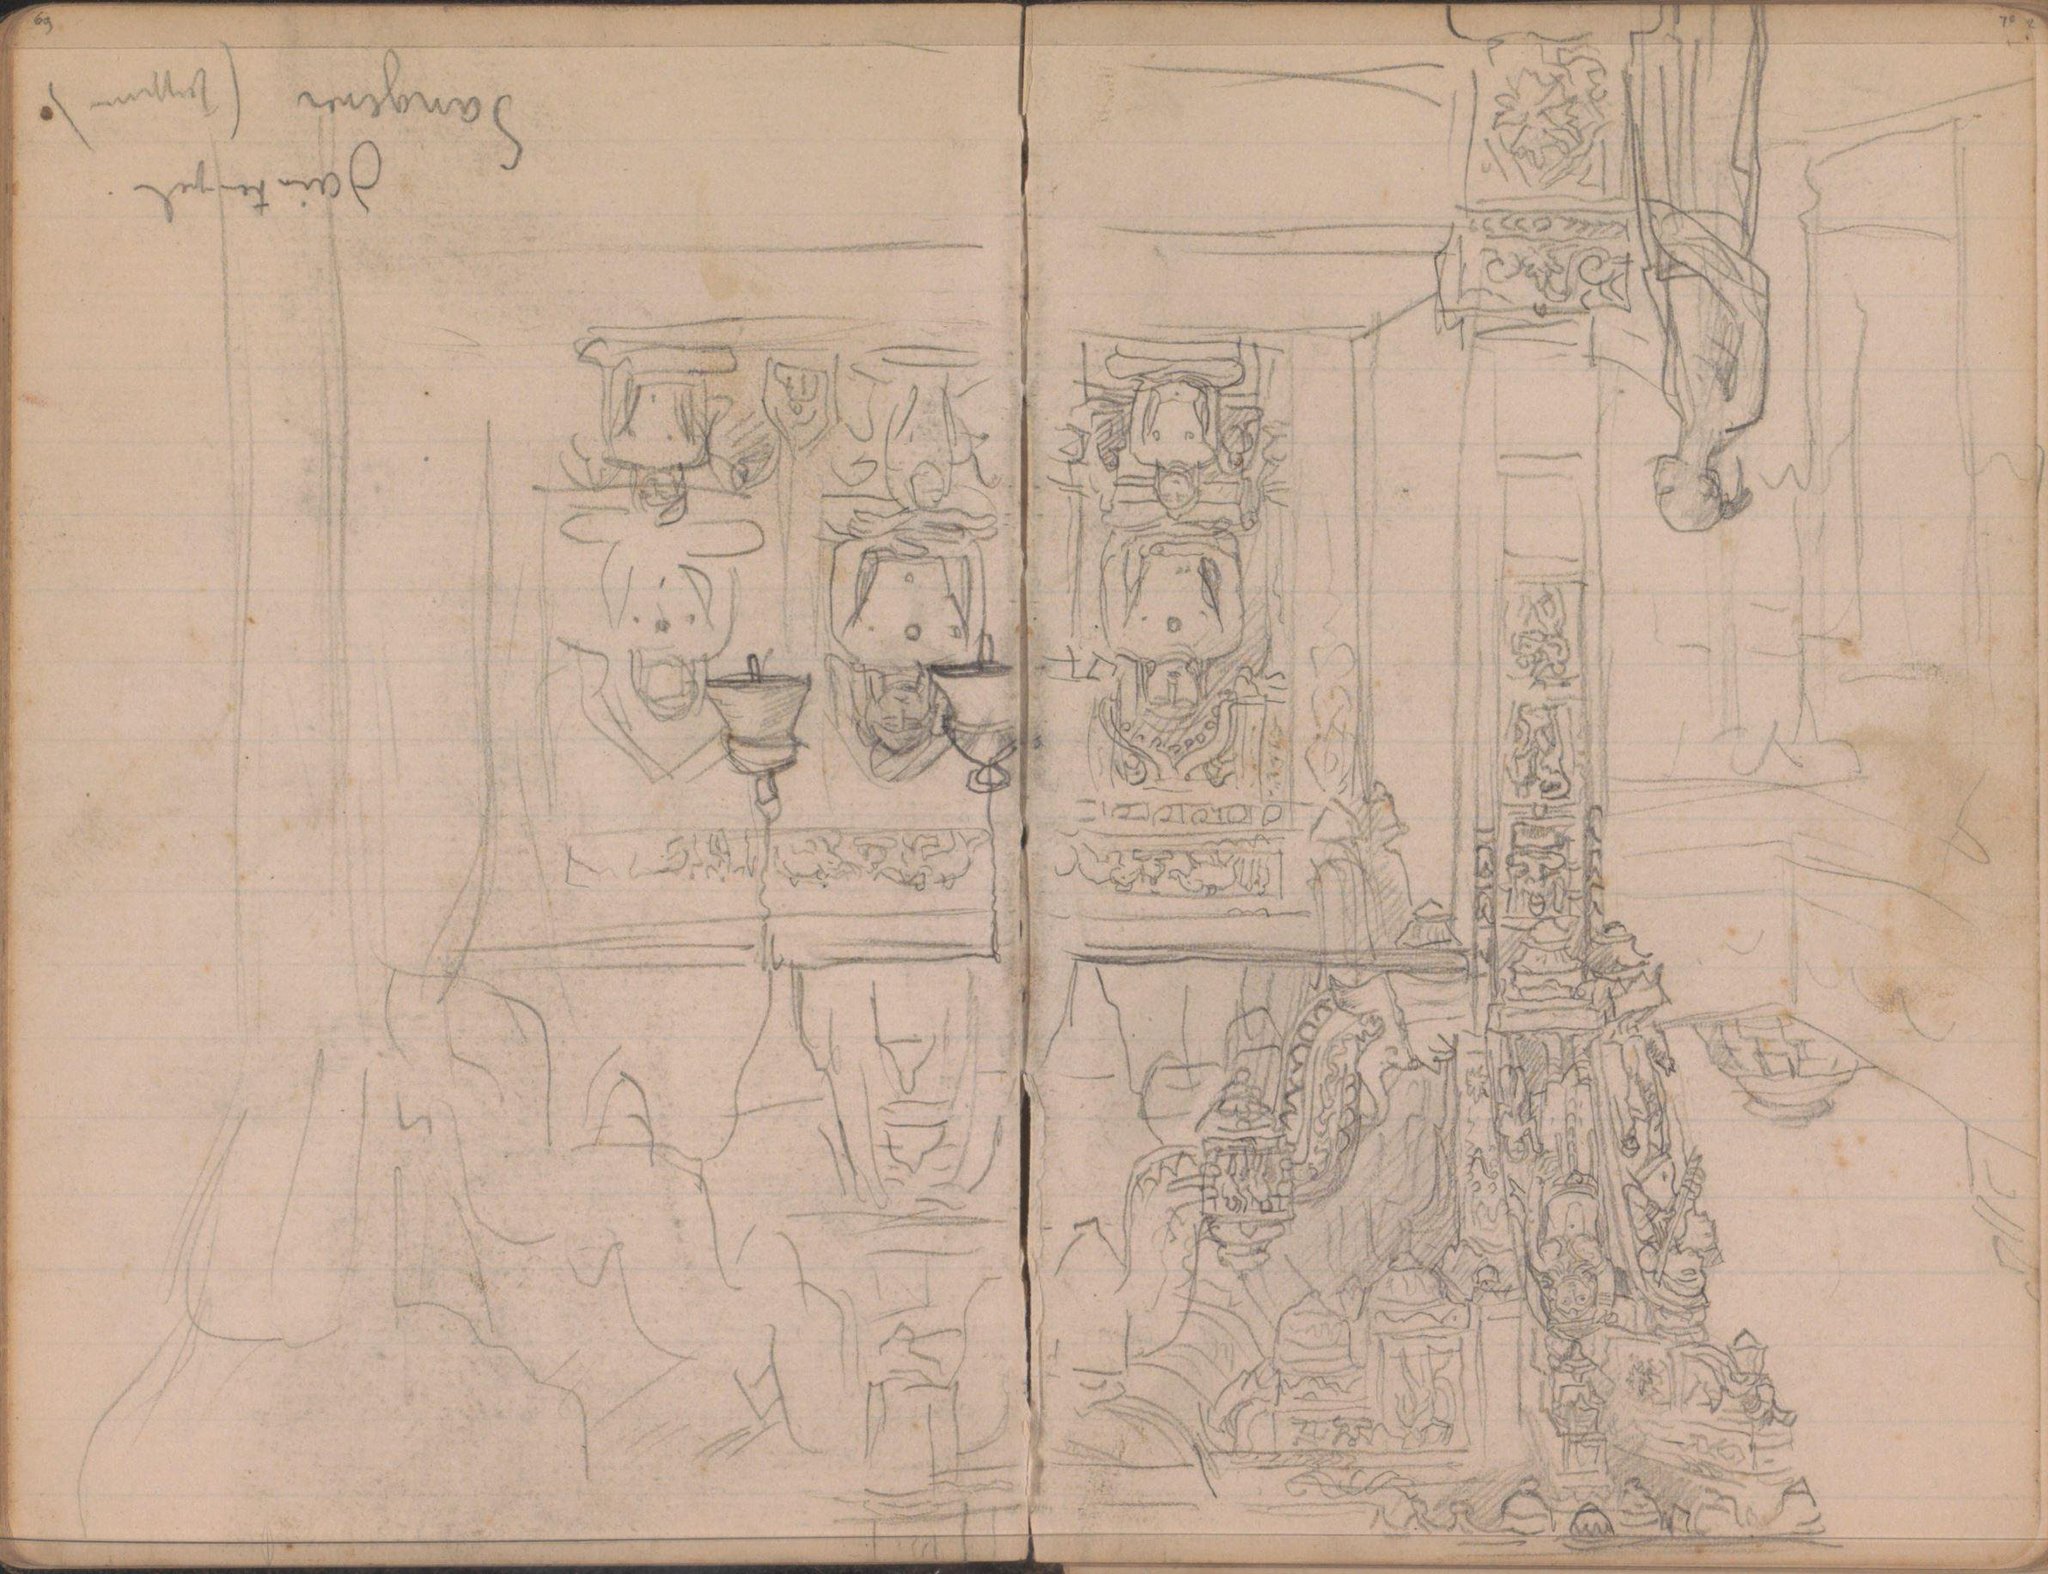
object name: sketchbook leaf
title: Indiër bij het altaar van een Jain tempel in Sanganer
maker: marius bauer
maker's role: draughtsman, print maker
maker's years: 1867-1932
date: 1897-1898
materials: pencil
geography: jaipur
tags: altar ~ hinduism, buddhism, jainism, asiatic races and peoples: indians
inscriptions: annotation: ‘Jain tempel/ Sangener (Jaypur)’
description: Pagina 69 en 70 uit een schetsboek met 84 bladen.